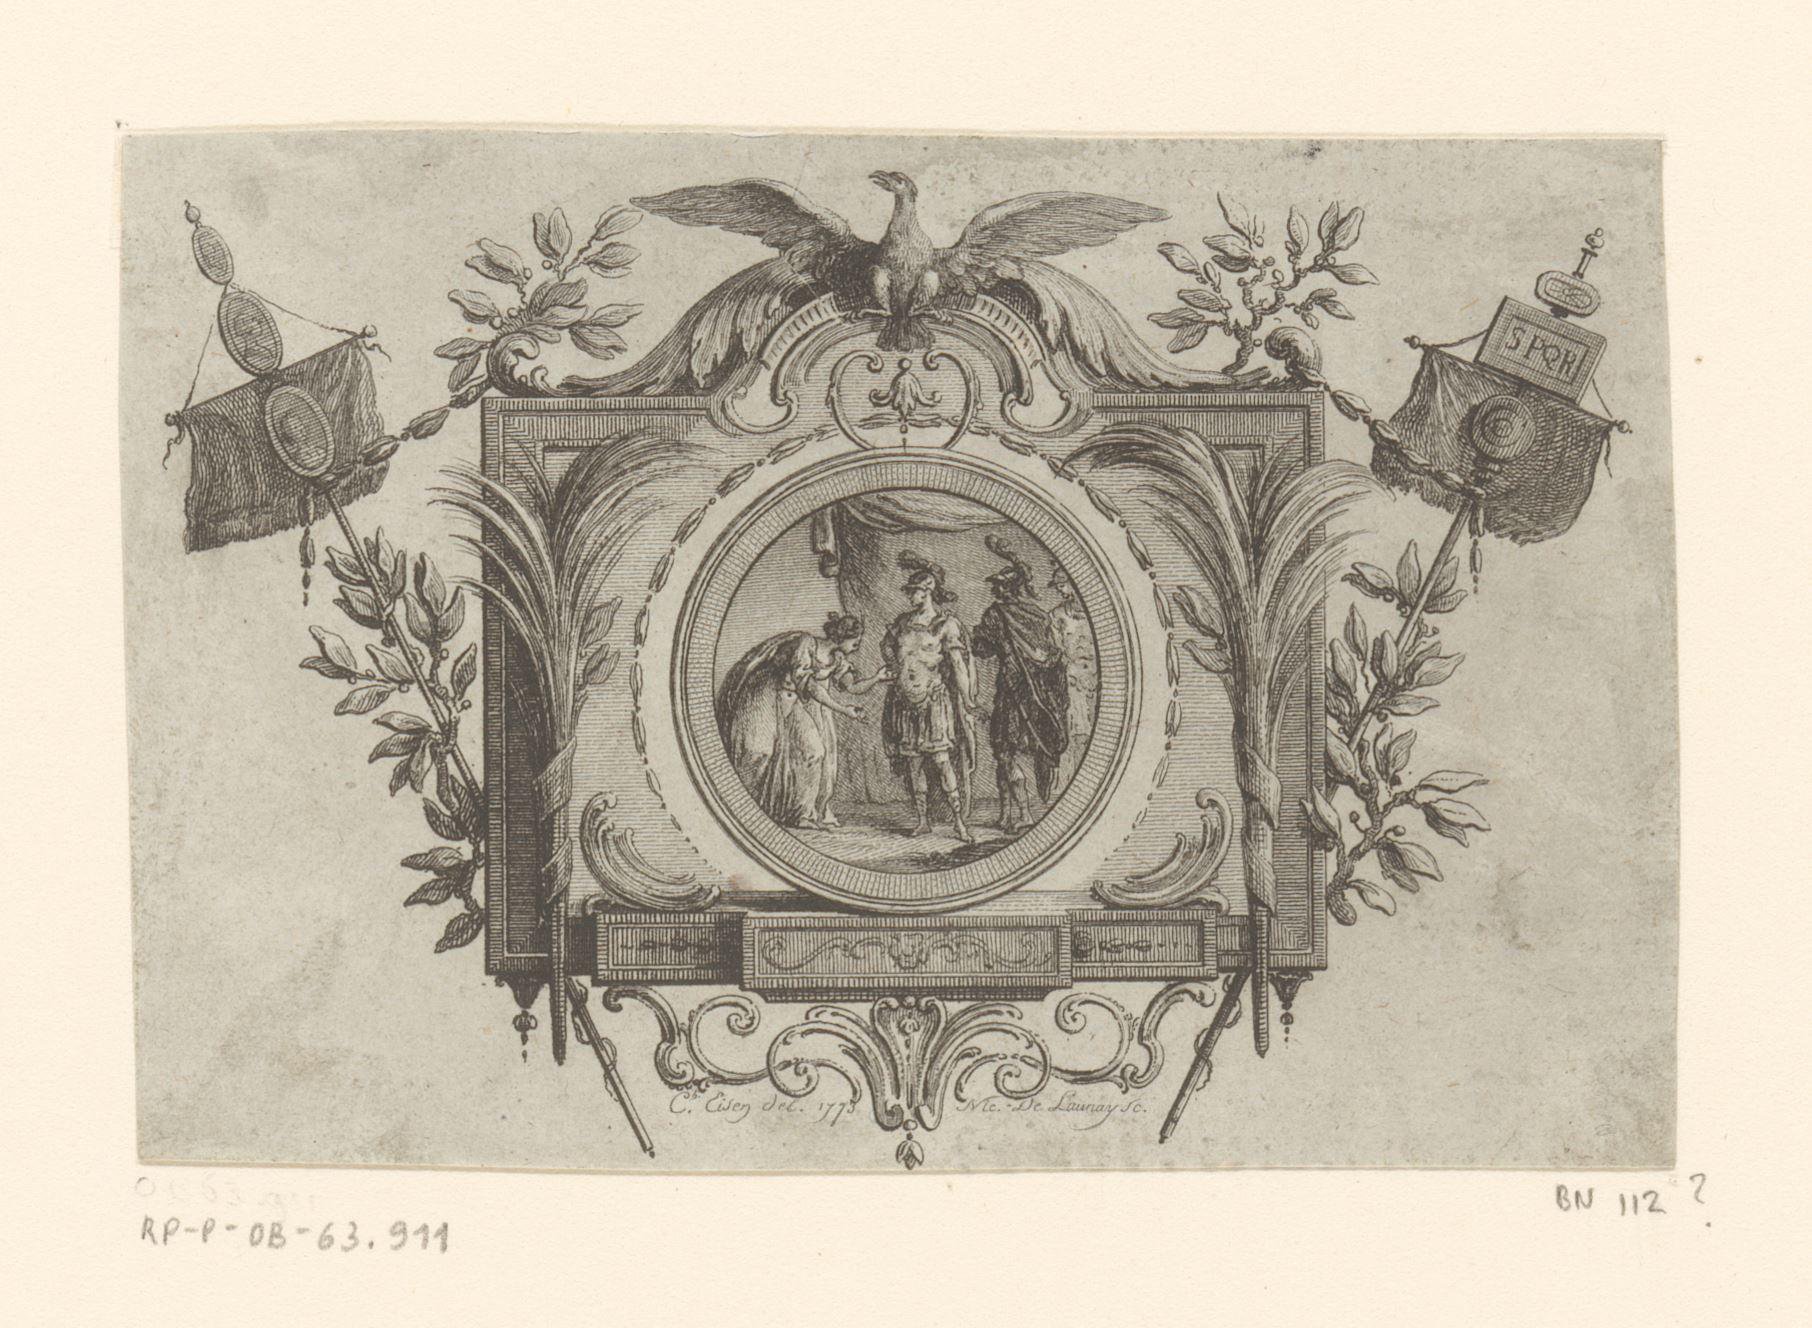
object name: print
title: Vignet met twee Romeinse soldaten en een vrouw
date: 1773-1792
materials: paper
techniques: engraving, etching, letterpress printing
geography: france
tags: soldiers and civilians, frame of painting, etc.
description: Mogelijk prent uit: Scévole S.l.s.n.s.a., p. 62.